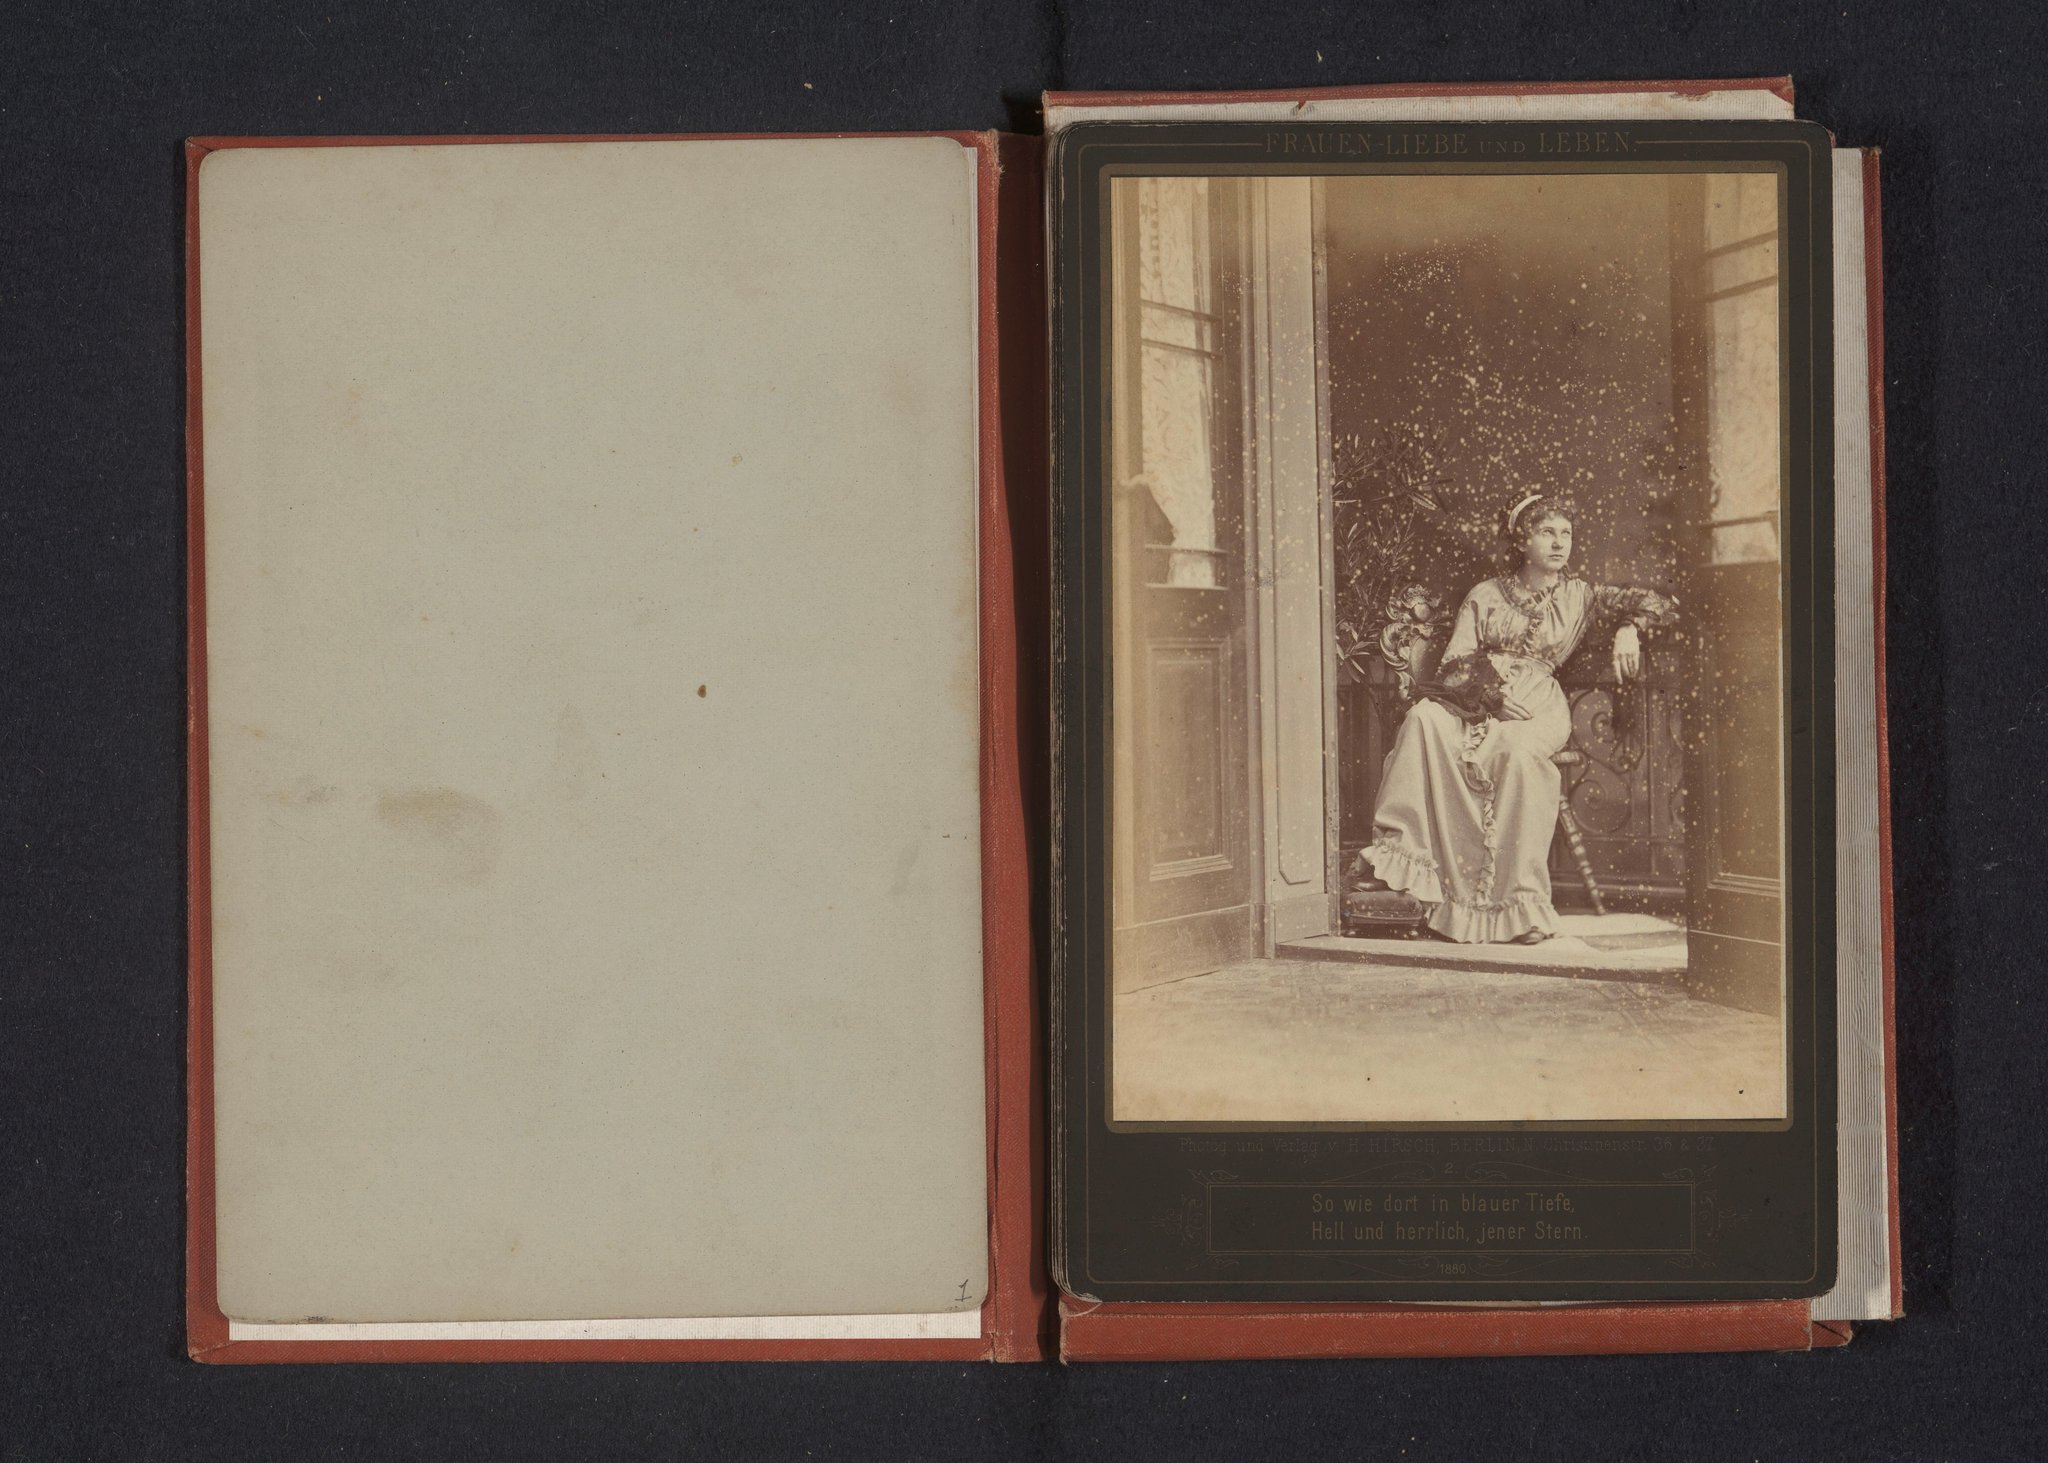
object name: photograph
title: Portret van een onbekende vrouw zittend op een balkon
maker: hugo hirsch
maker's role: publisher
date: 1880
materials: photographic support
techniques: albumen print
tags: adult woman, balcony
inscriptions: name: ‘Photog. und Verlag v. H. Hirsch, Berlin, N Christinenstr. 36 & 37’, number: ‘2.’